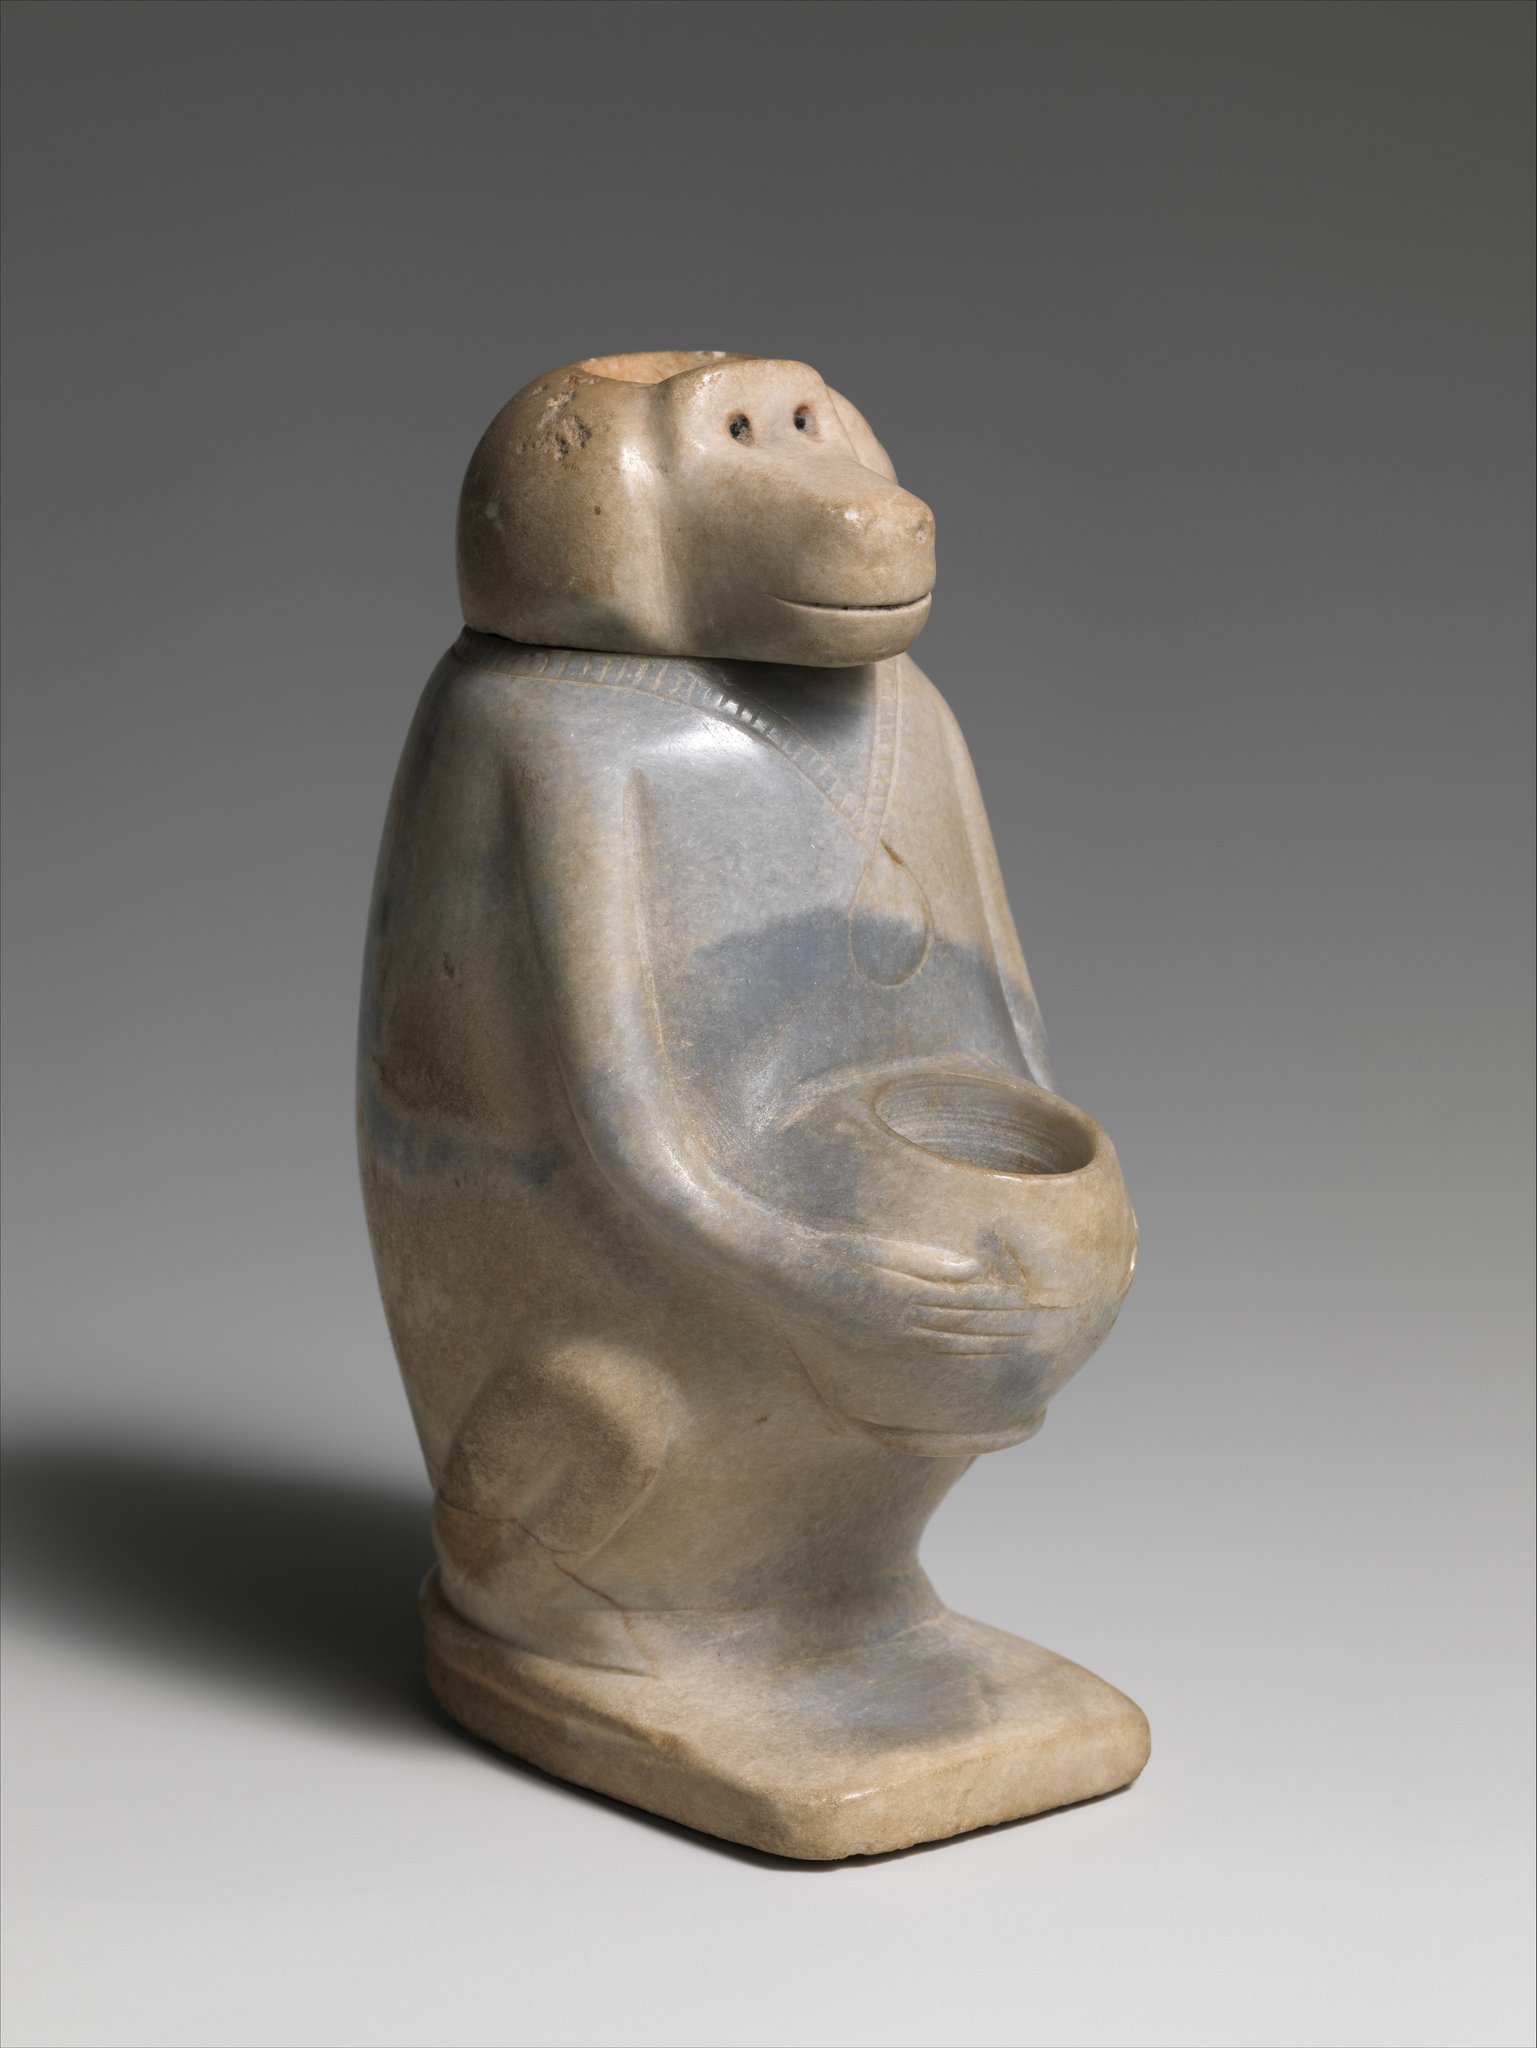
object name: ointment jar, baboon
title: Ointment jar in the shape of a baboon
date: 1800-1550 BCE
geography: northern upper egypt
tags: baboons